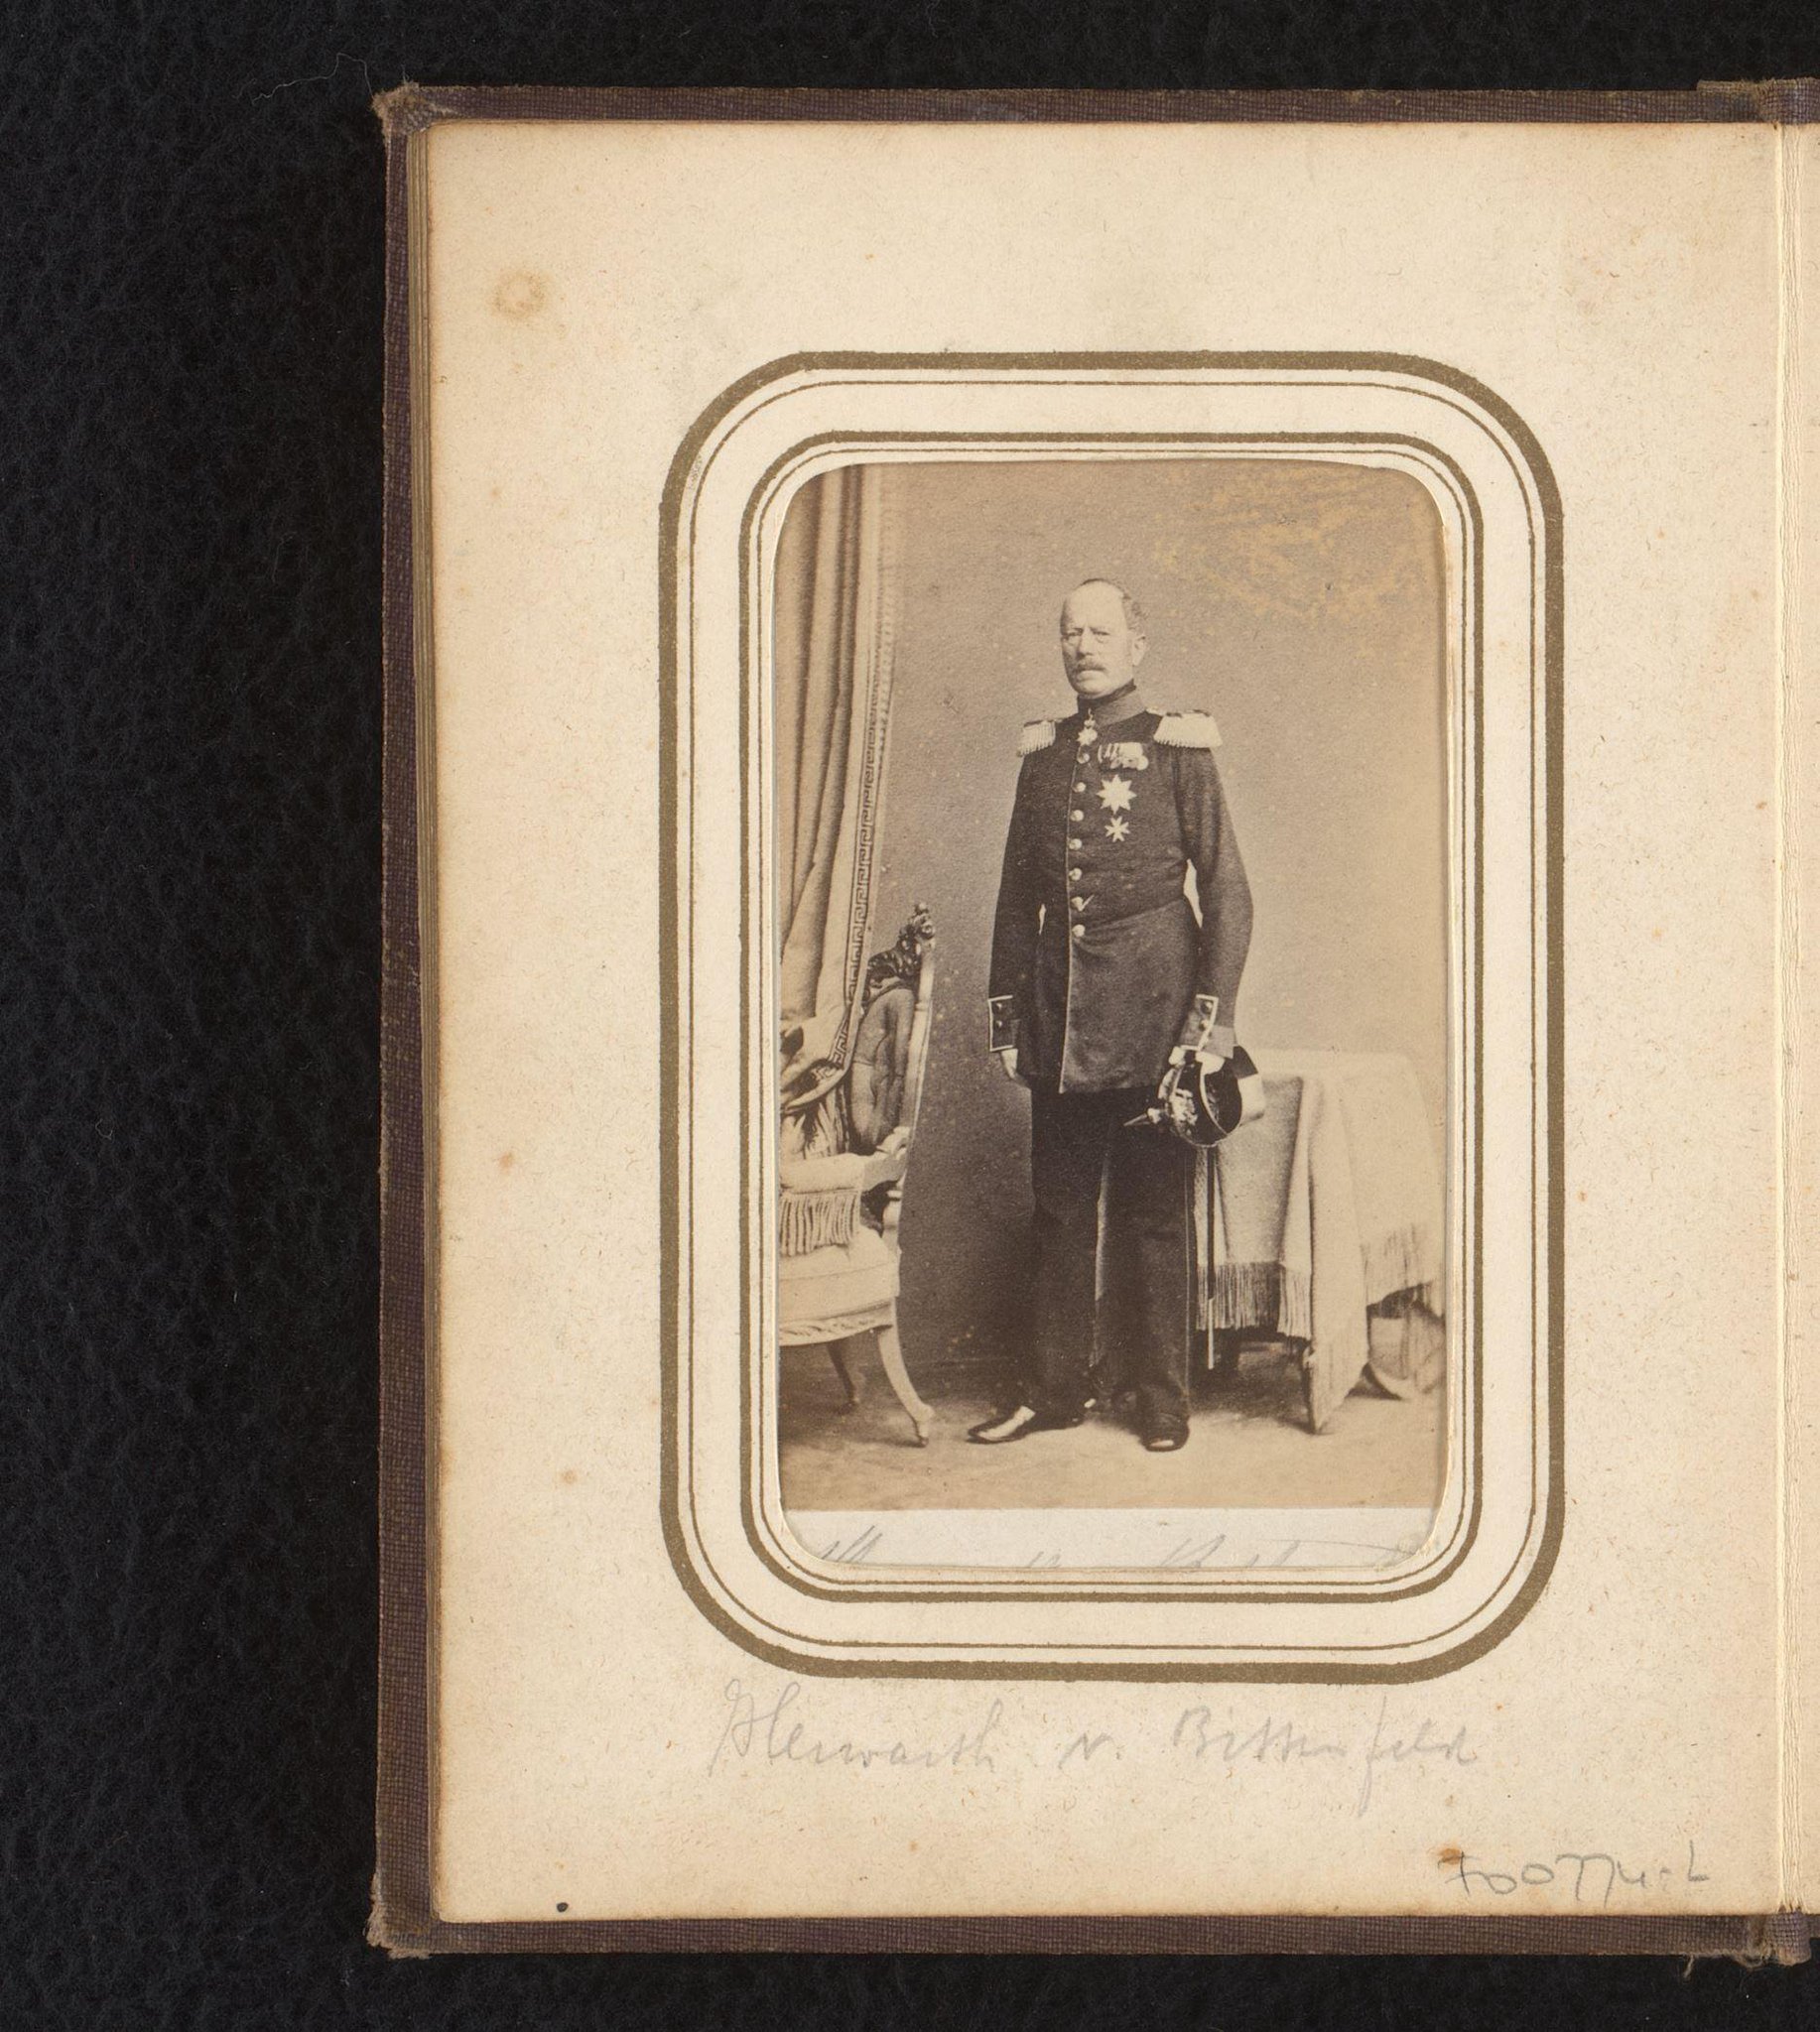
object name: album leaf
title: Portret van Karl Eberhard Herwarth von Bittenfeld in uniform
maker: Anonymous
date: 1860-1876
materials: cardboard, photographic support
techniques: albumen print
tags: historical persons, (military) uniforms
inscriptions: name: ‘Herwarth v. Bittenfeld’, name: ‘Herwarth v Bittenfeld’